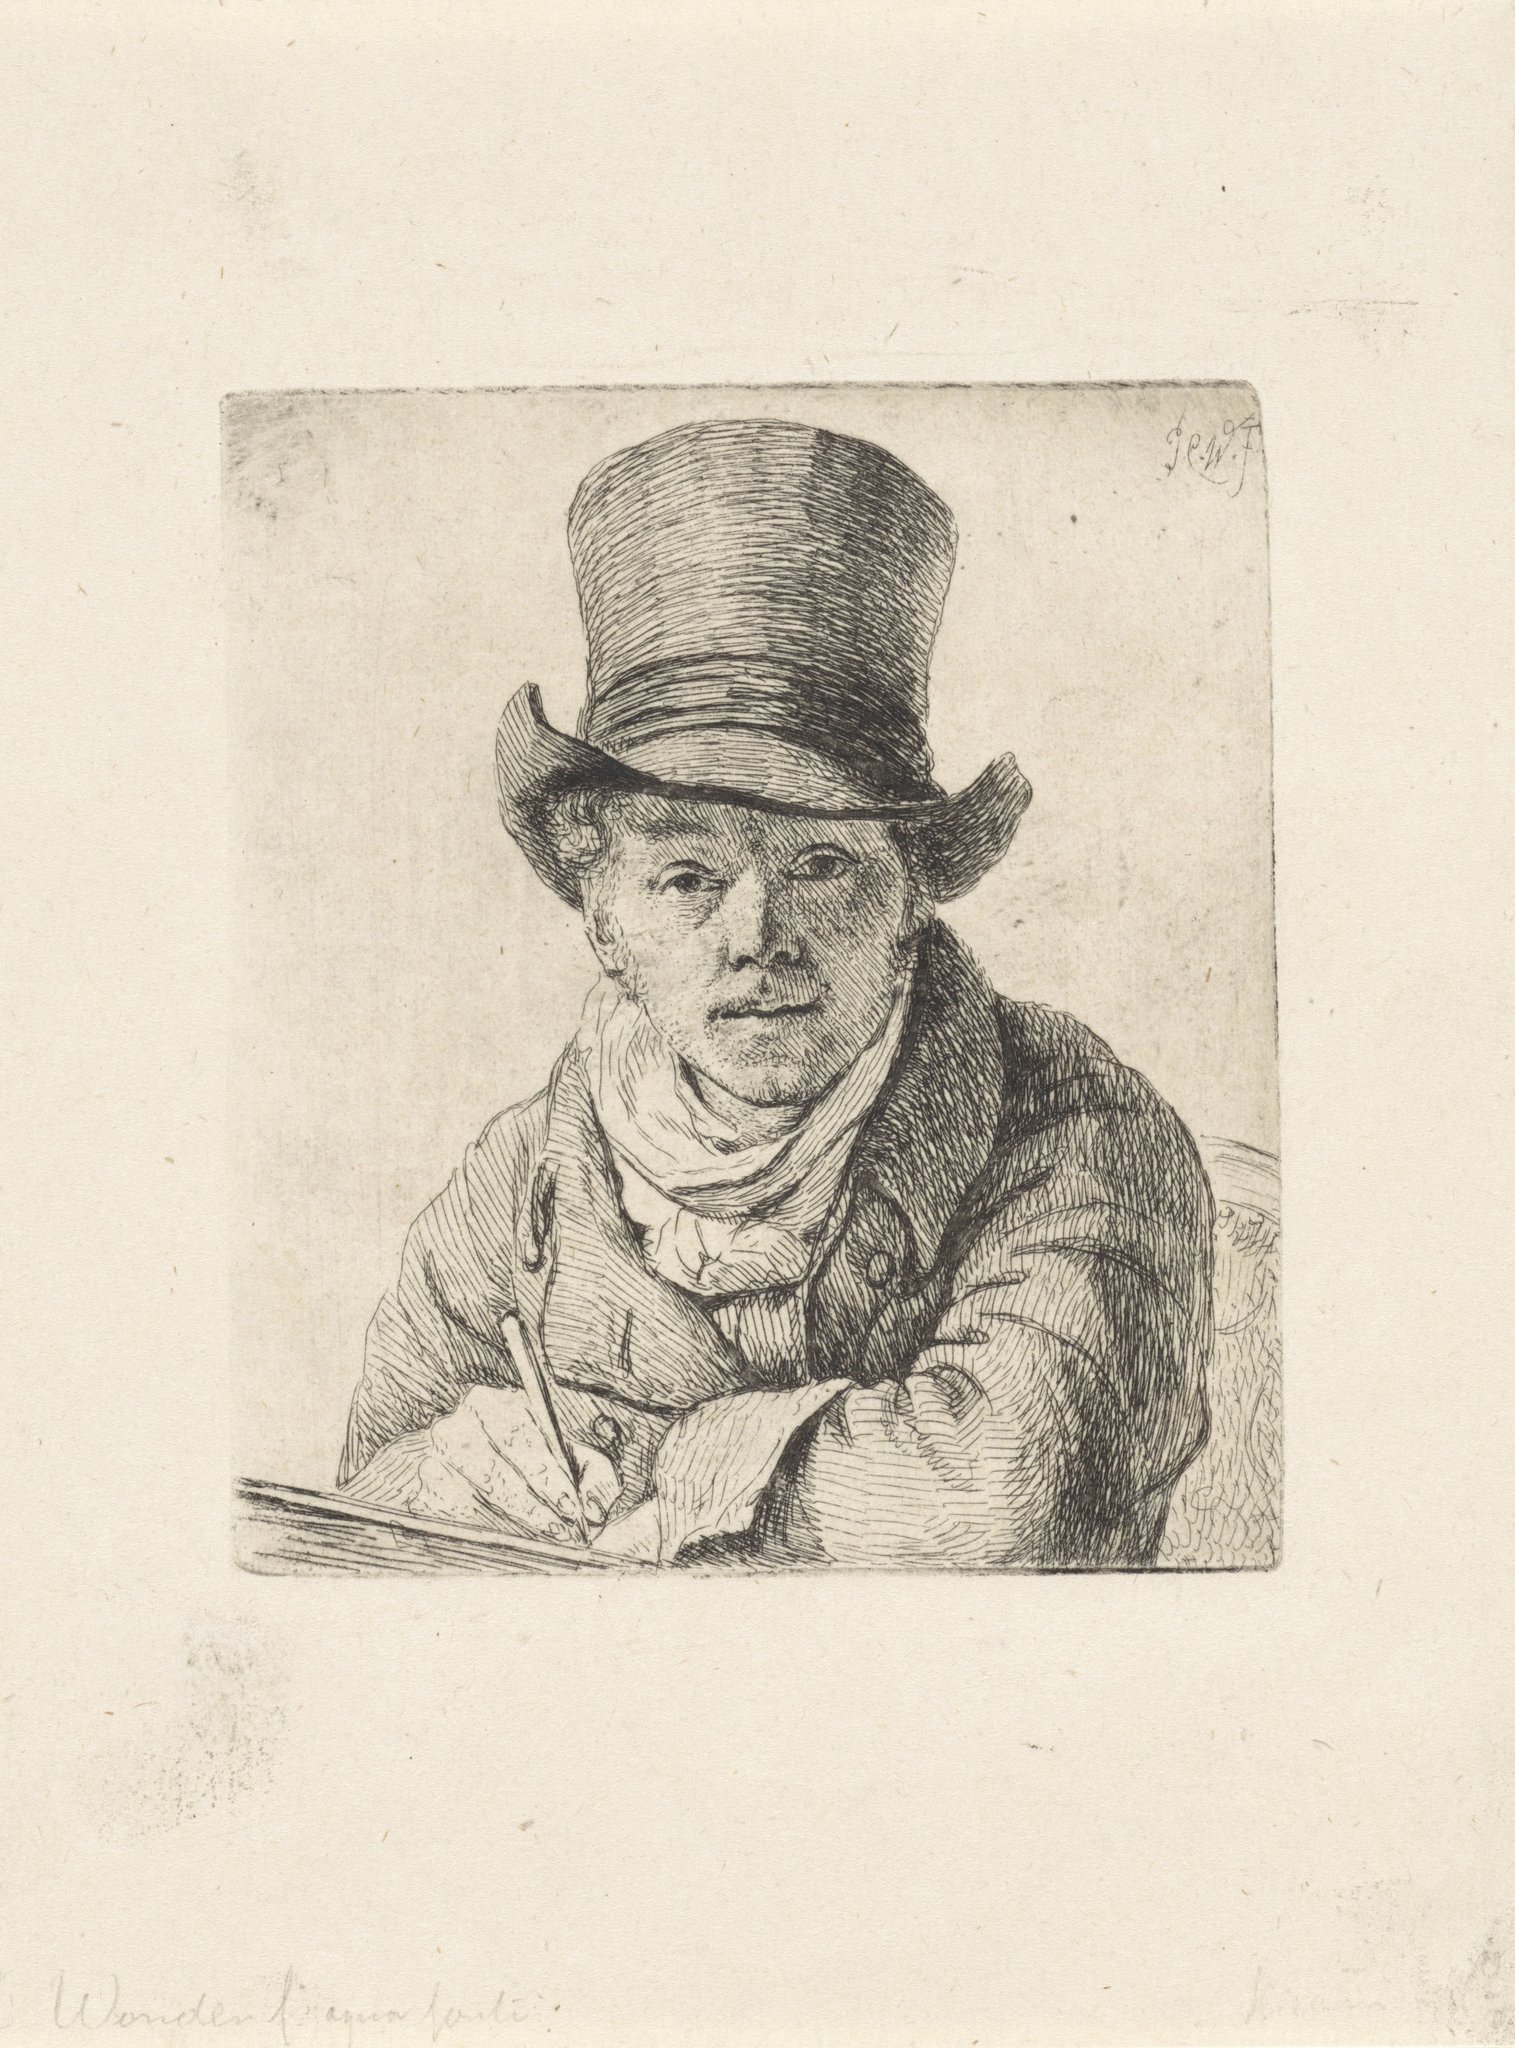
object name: print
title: Zelfportret van Pieter Christoffel Wonder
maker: pieter christoffel wonder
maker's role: draughtsman, painter, print maker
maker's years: 1780-1852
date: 1802-1816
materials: paper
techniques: etching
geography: utrecht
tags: portrait, self-portrait of artist (+ artist at work)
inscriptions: collector's mark: Lugt 2228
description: Zelfportret van de kunstenaar Pieter Christoffel Wonder. Hij draagt een hoge hoed en tekent aan een tafel.